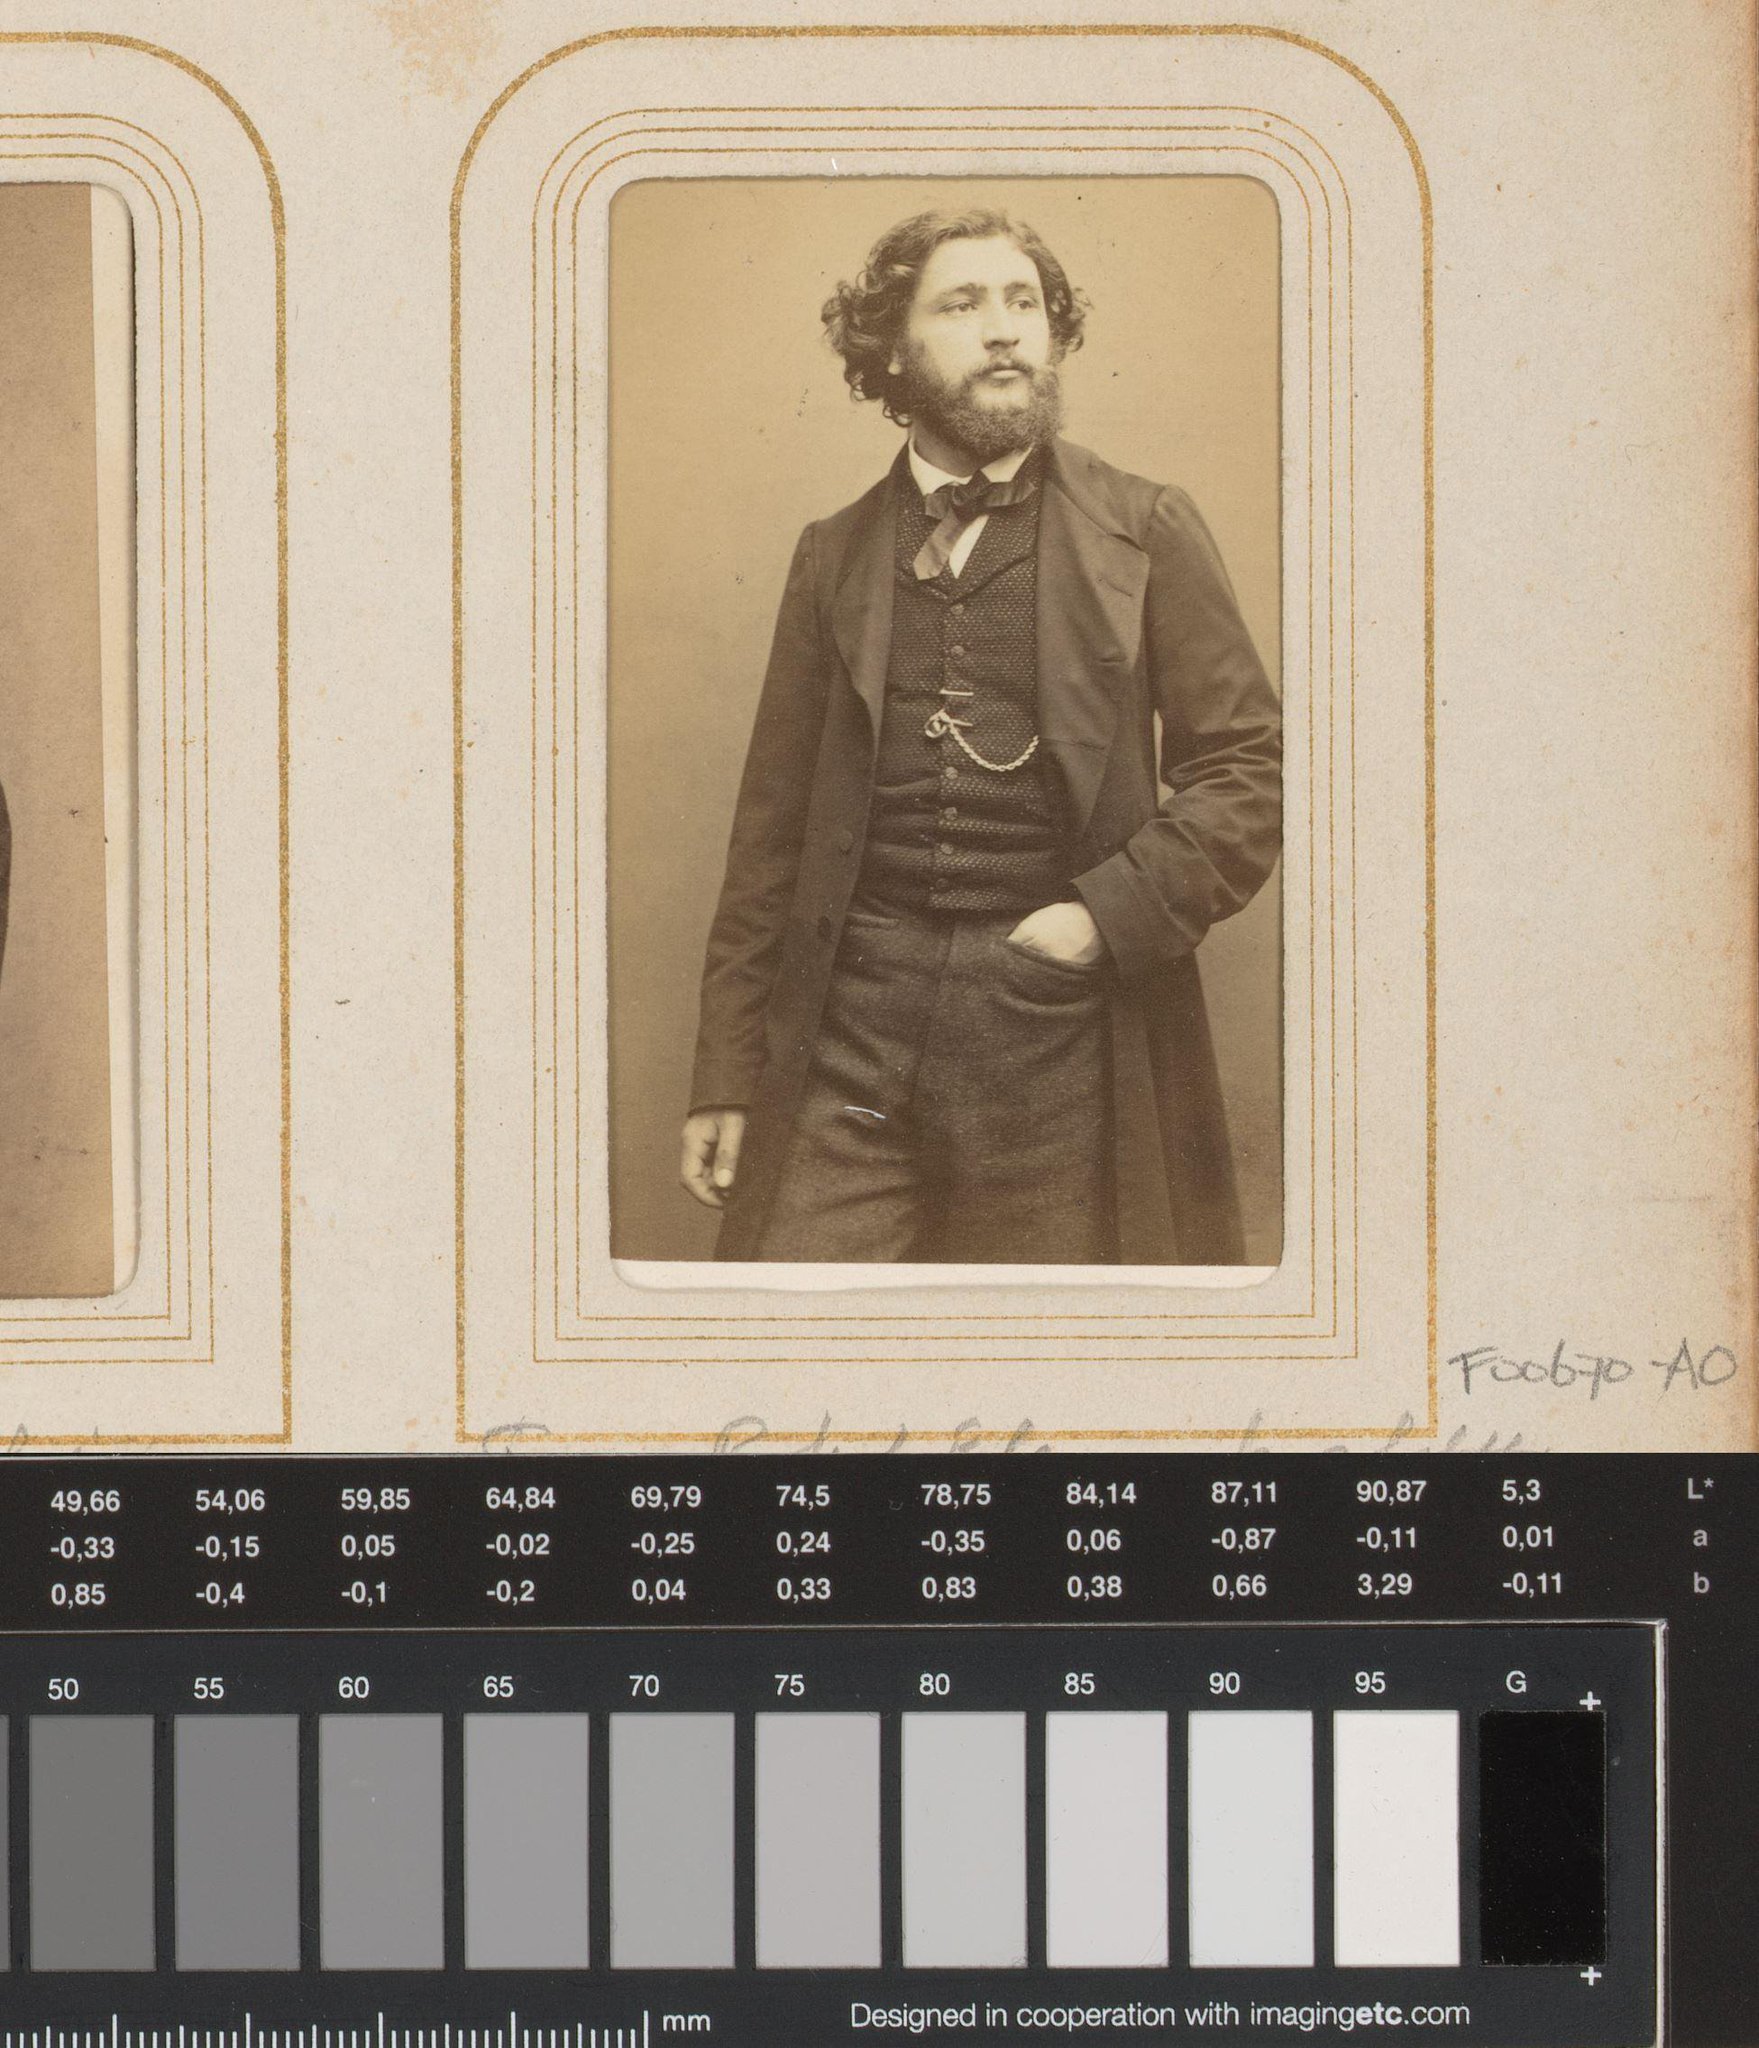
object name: album leaf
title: Portret van Tony Robert-Fleury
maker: étienne carjat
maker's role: draughtsman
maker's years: 1828-1906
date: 1861-1867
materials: cardboard, photographic support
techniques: albumen print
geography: paris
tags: painter, draughtsman, tony robert-fleury, historical persons, portrait, self-portrait of painter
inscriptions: name: ‘Tony Robert Fleury’, annotation: ‘Tony Robert-Fleury fr. schilder/ 1837-1890 (Carjat)’, inscription: ‘Carjat & Cie/ 56, Rue Laffitte/ Paris’